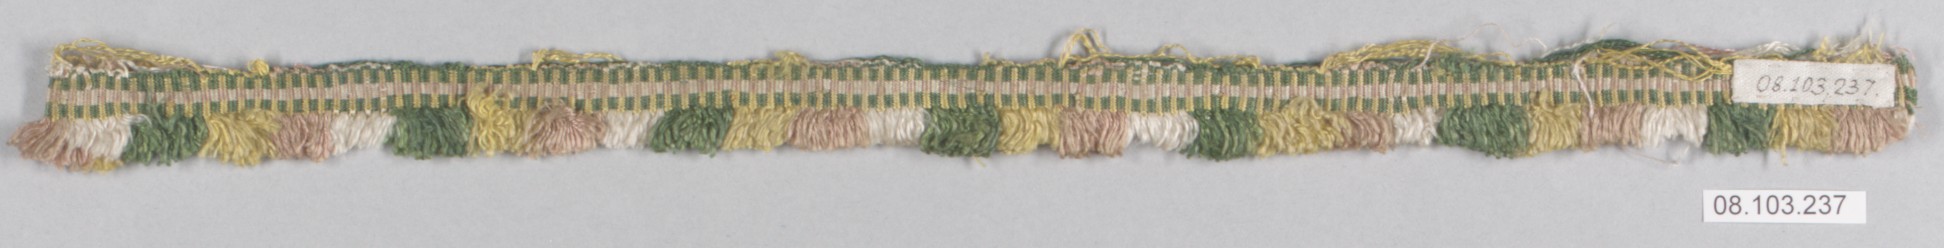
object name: gimp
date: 1701-1800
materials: silk